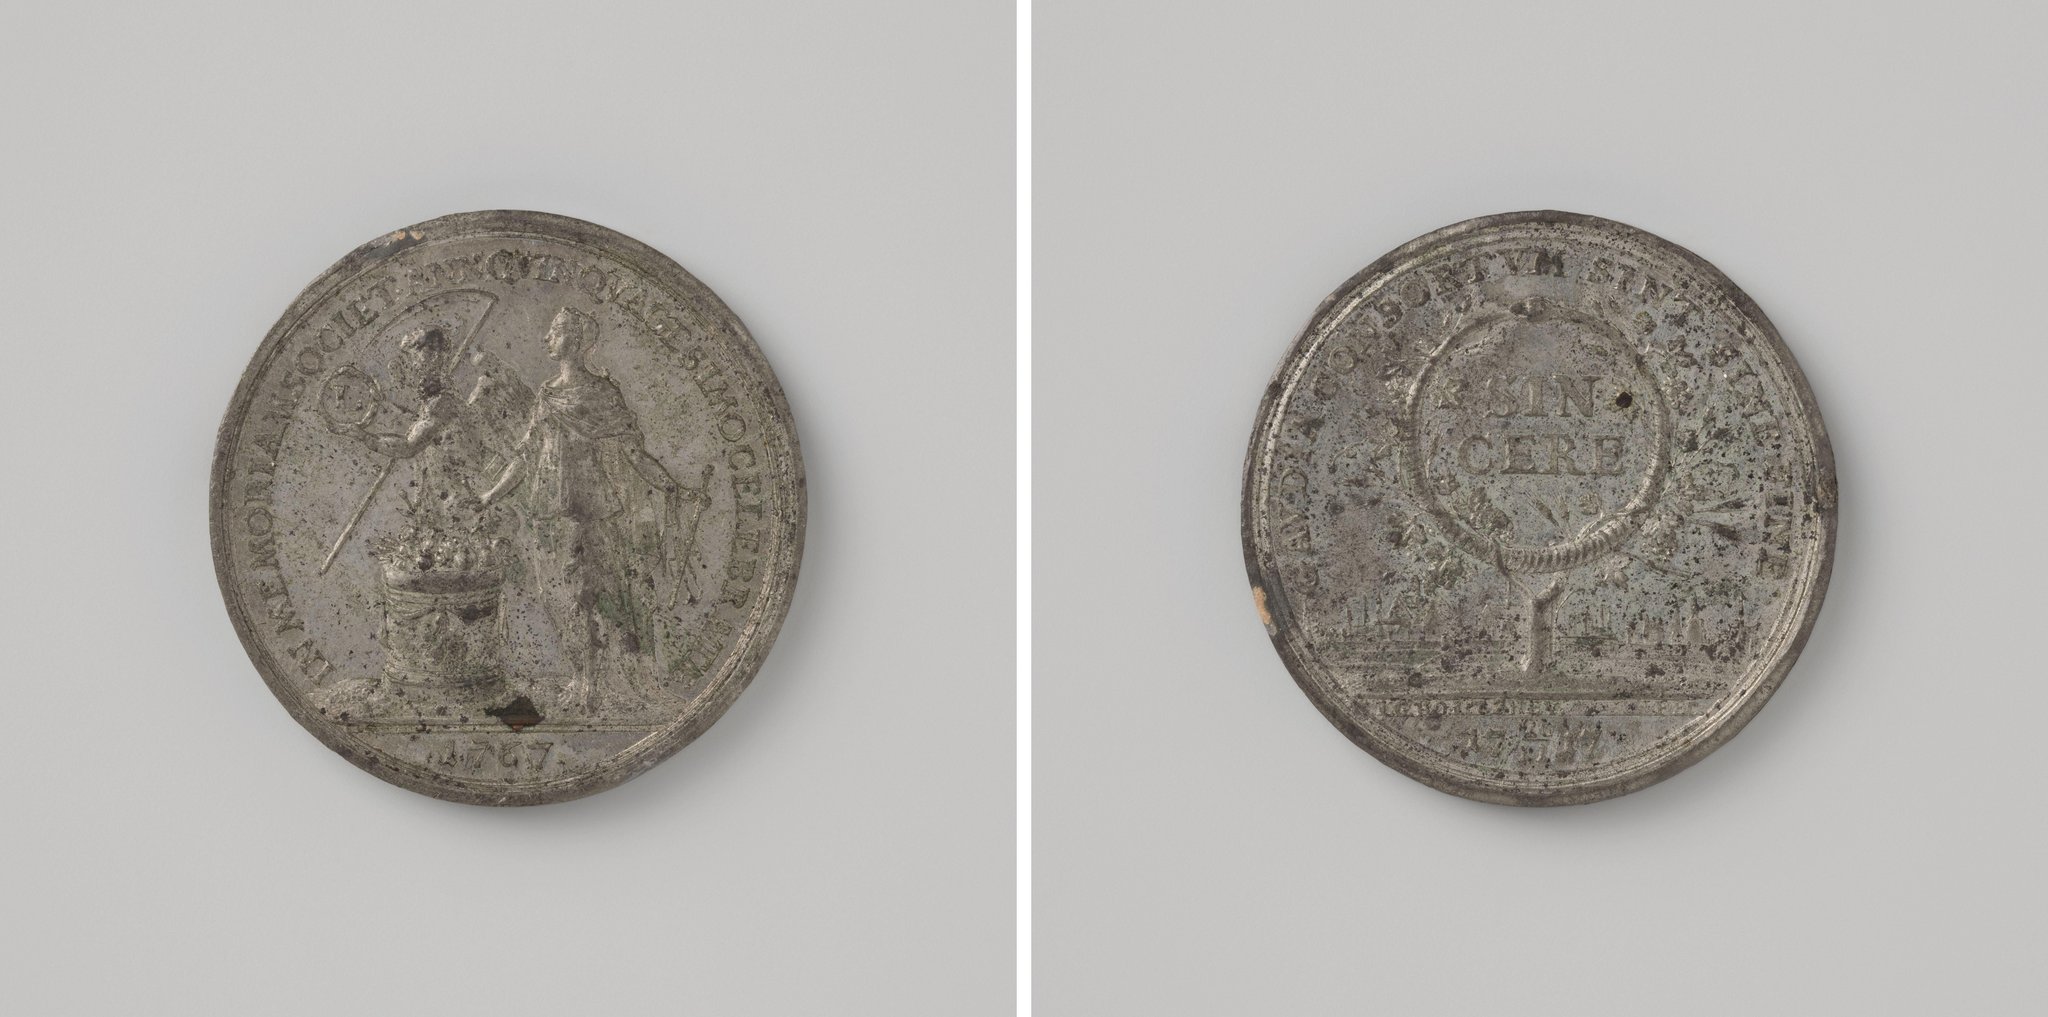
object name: history medal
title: 50-jarig bestaan van het genootschap 'Het Slangennest’, 1767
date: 1767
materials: lead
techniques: striking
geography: amsterdam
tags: genootschap het slangennest